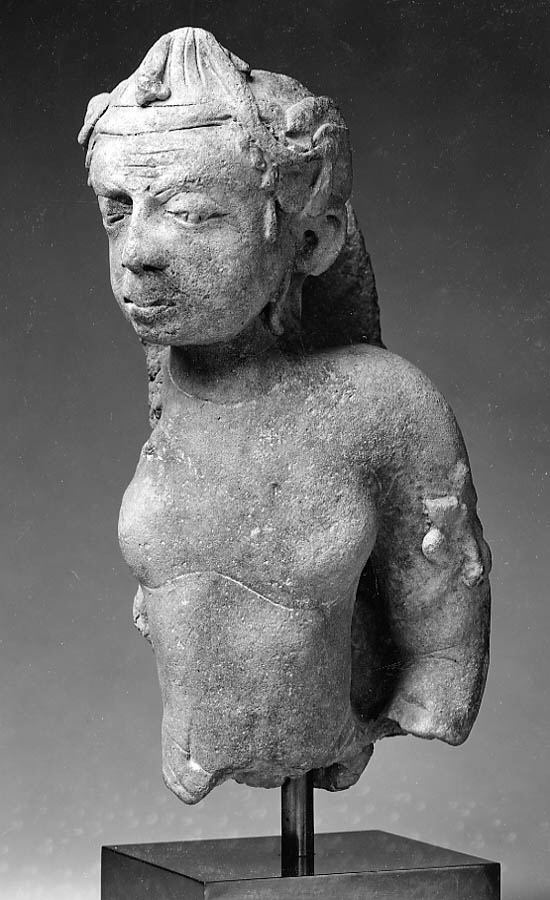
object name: figure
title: Male Figure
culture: indian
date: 401-500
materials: terracotta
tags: gupta,men